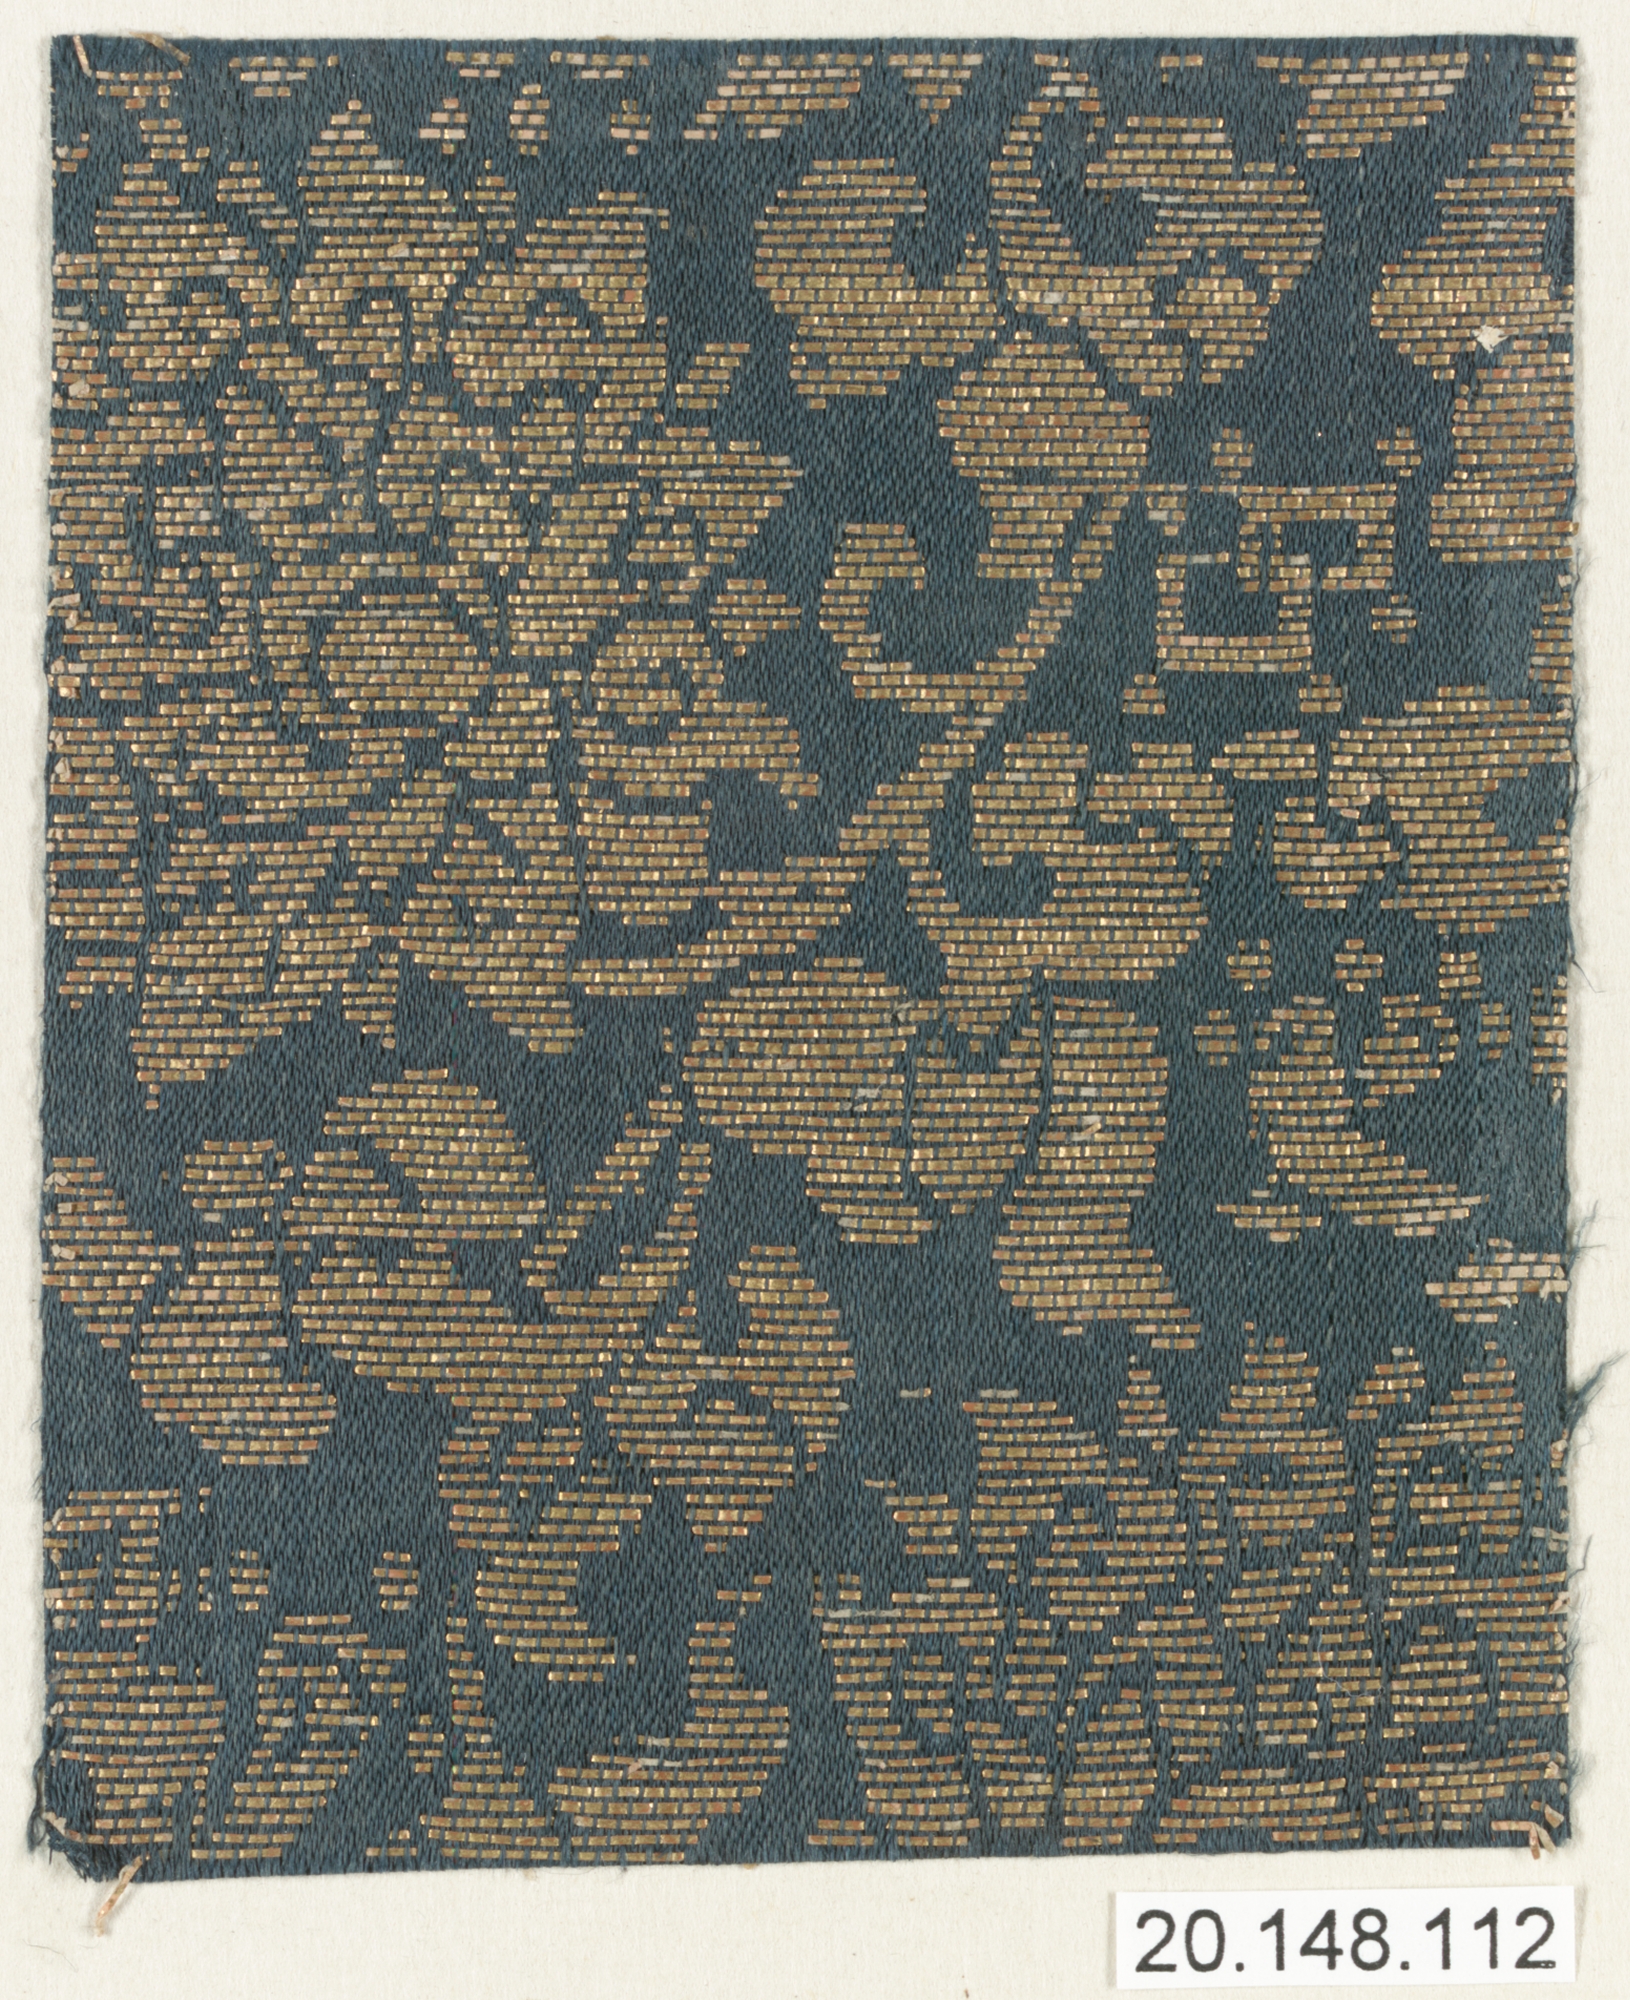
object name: piece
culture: japanese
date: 1701-1800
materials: silk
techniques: compound weave